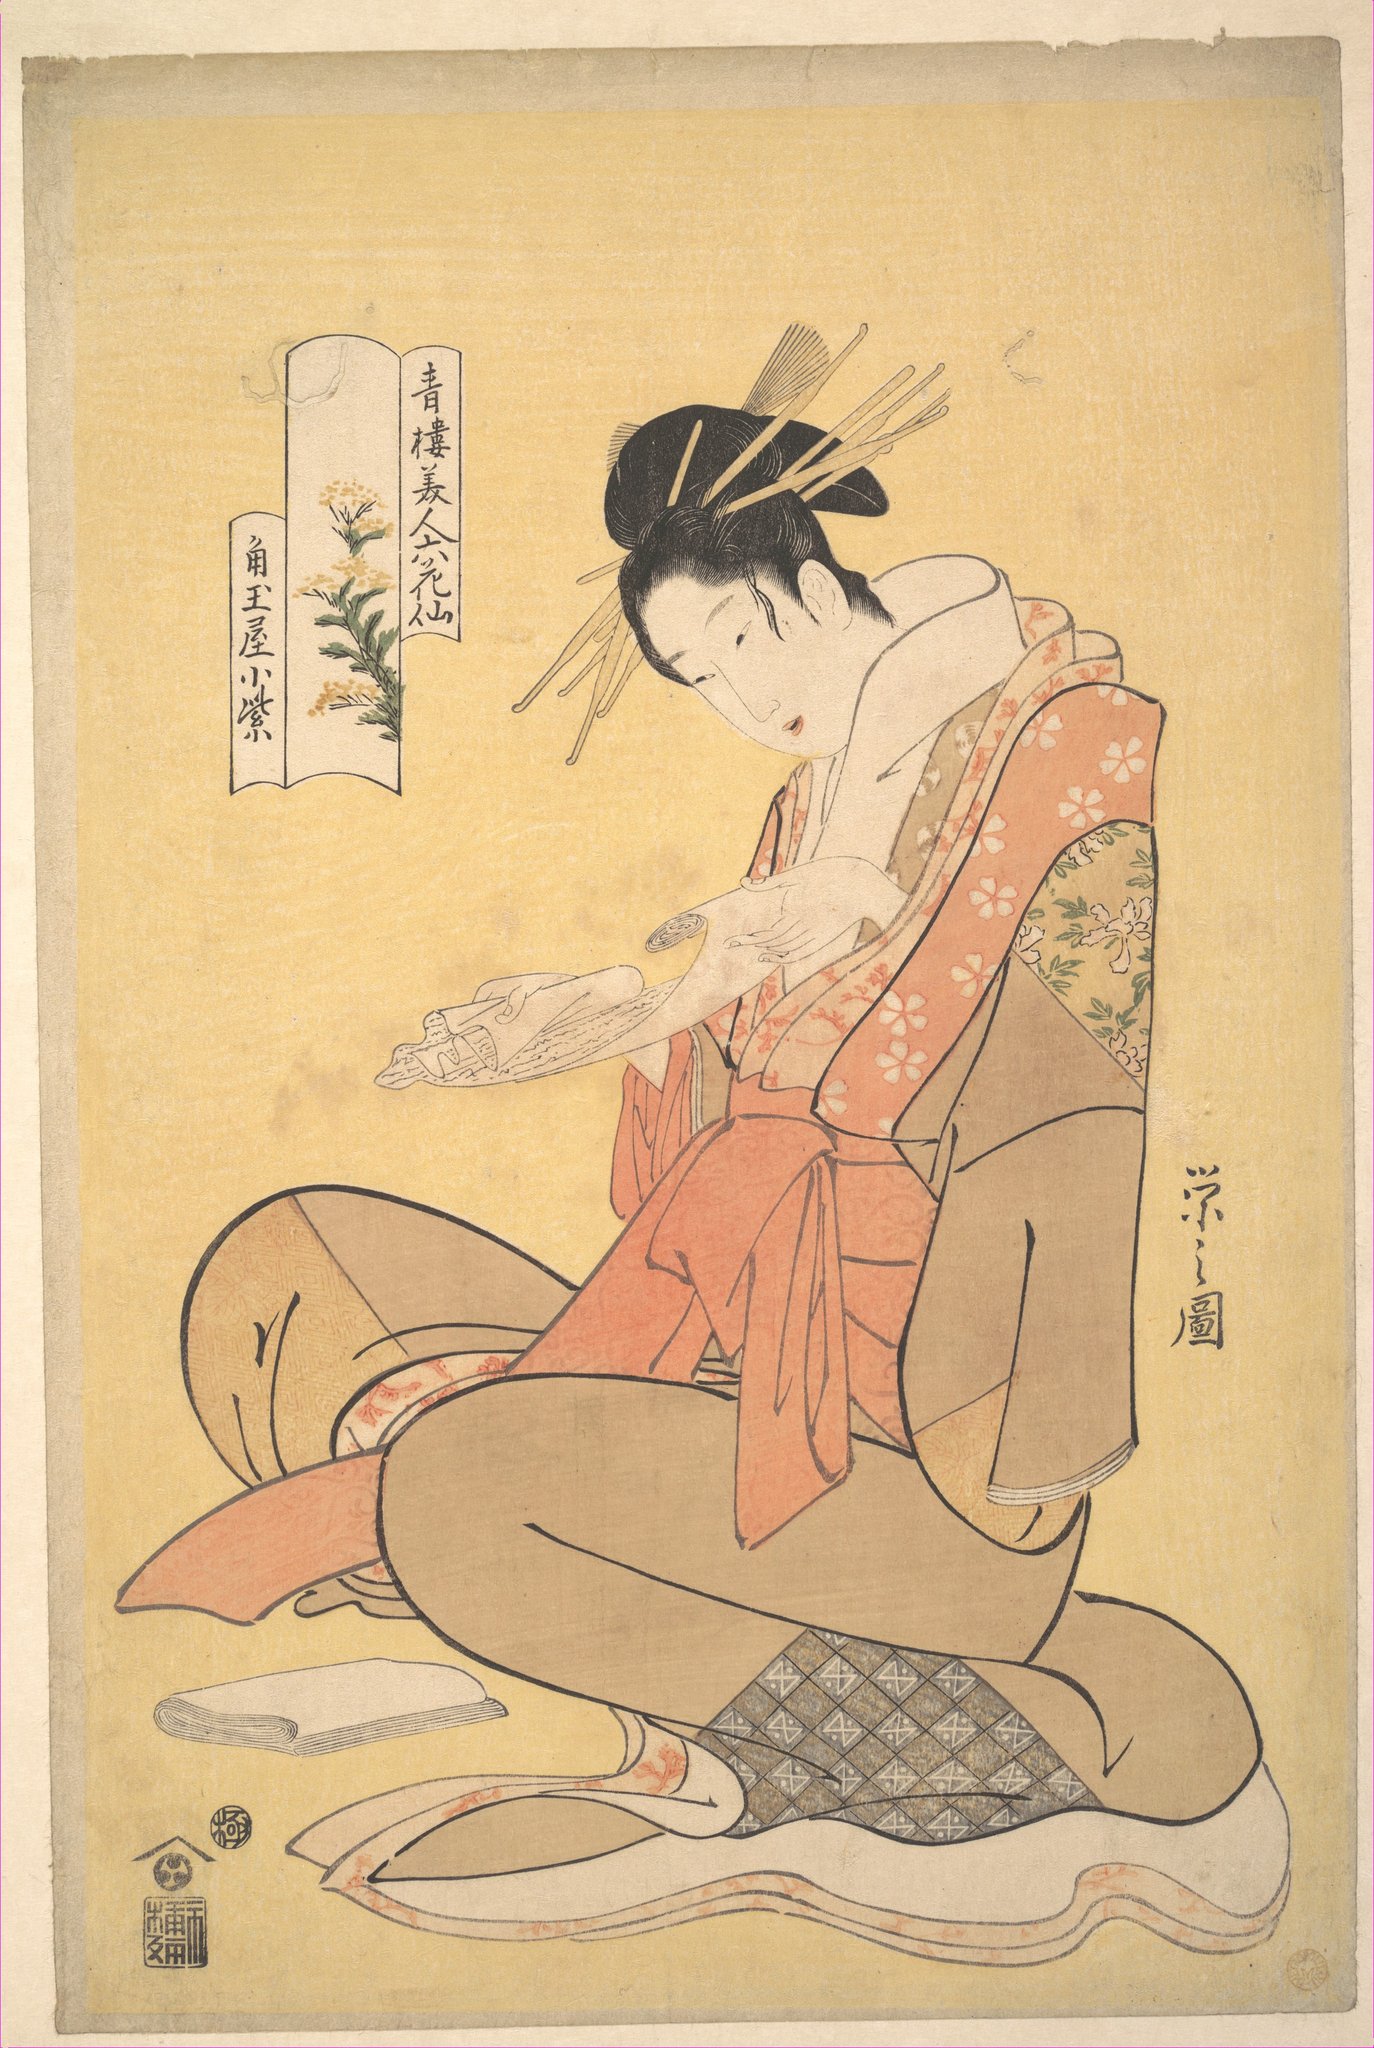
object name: print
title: The Oiran Komurasaki of Kadotamaya Reading a Letter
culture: japanese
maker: chōbunsai eishi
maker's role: artist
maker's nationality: japanese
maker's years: 1756-1829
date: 1794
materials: ink, paper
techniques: woodblock print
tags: women,reading